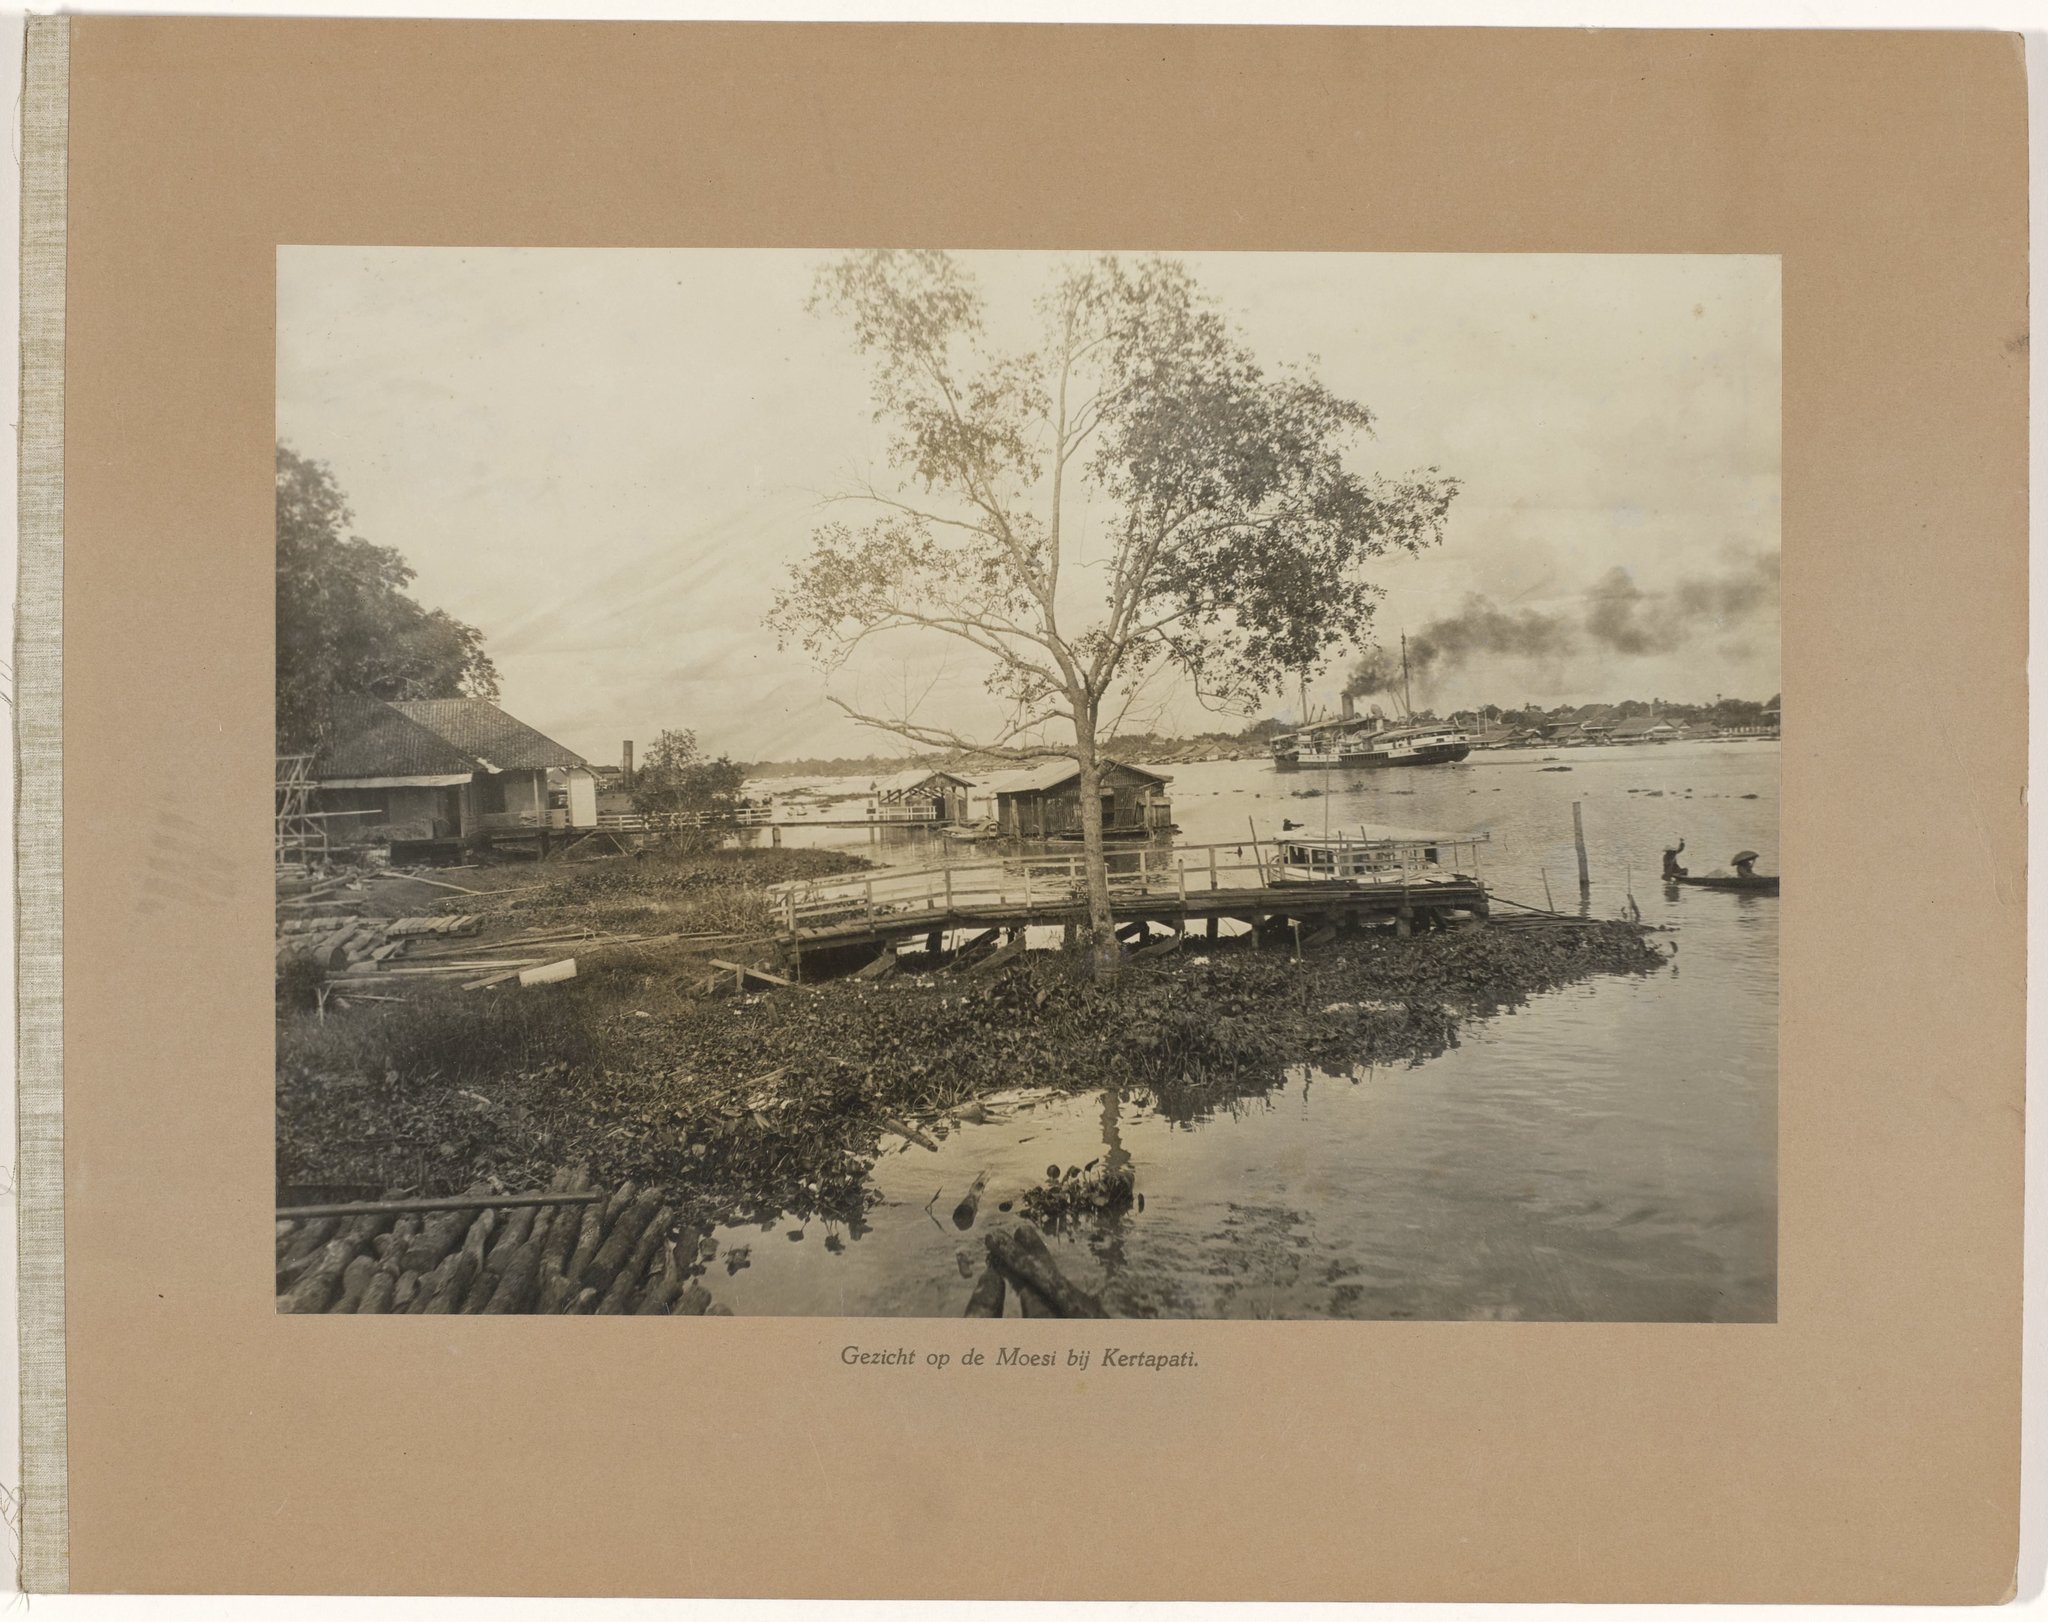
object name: photograph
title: Gezicht op de Moesi bij Kertapati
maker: Anonymous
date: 1921-1922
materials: photographic support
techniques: gelatin silver print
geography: bukit asam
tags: colonial system, anthracite, hard coal, river, opencast mine; strip mining (+ coal), sumatra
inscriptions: inscription: ‘Gezicht op de Moesi bij Kertapati.’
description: Gezicht op de rivier Air Musi (Moesi) bij Kertapati met op het water een opstomende kolenstomer. In Kertapati bevond zich een opslagplaats voor kolen voor verdere transport over zee. Onderdeel van het losbladige fotoalbum aangeboden door het personeel van de Boekit-Asam Steenkolenmijnen op Sumatra aan de scheidende Ingenieur-Directeur H. Tromp op 7 januari 1922.